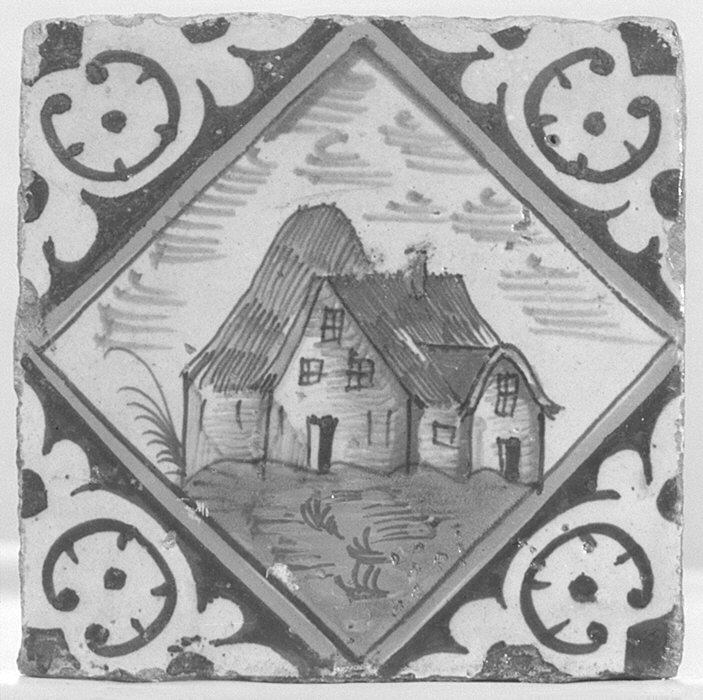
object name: tile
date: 1580-1625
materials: earthenware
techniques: glazing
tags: houses